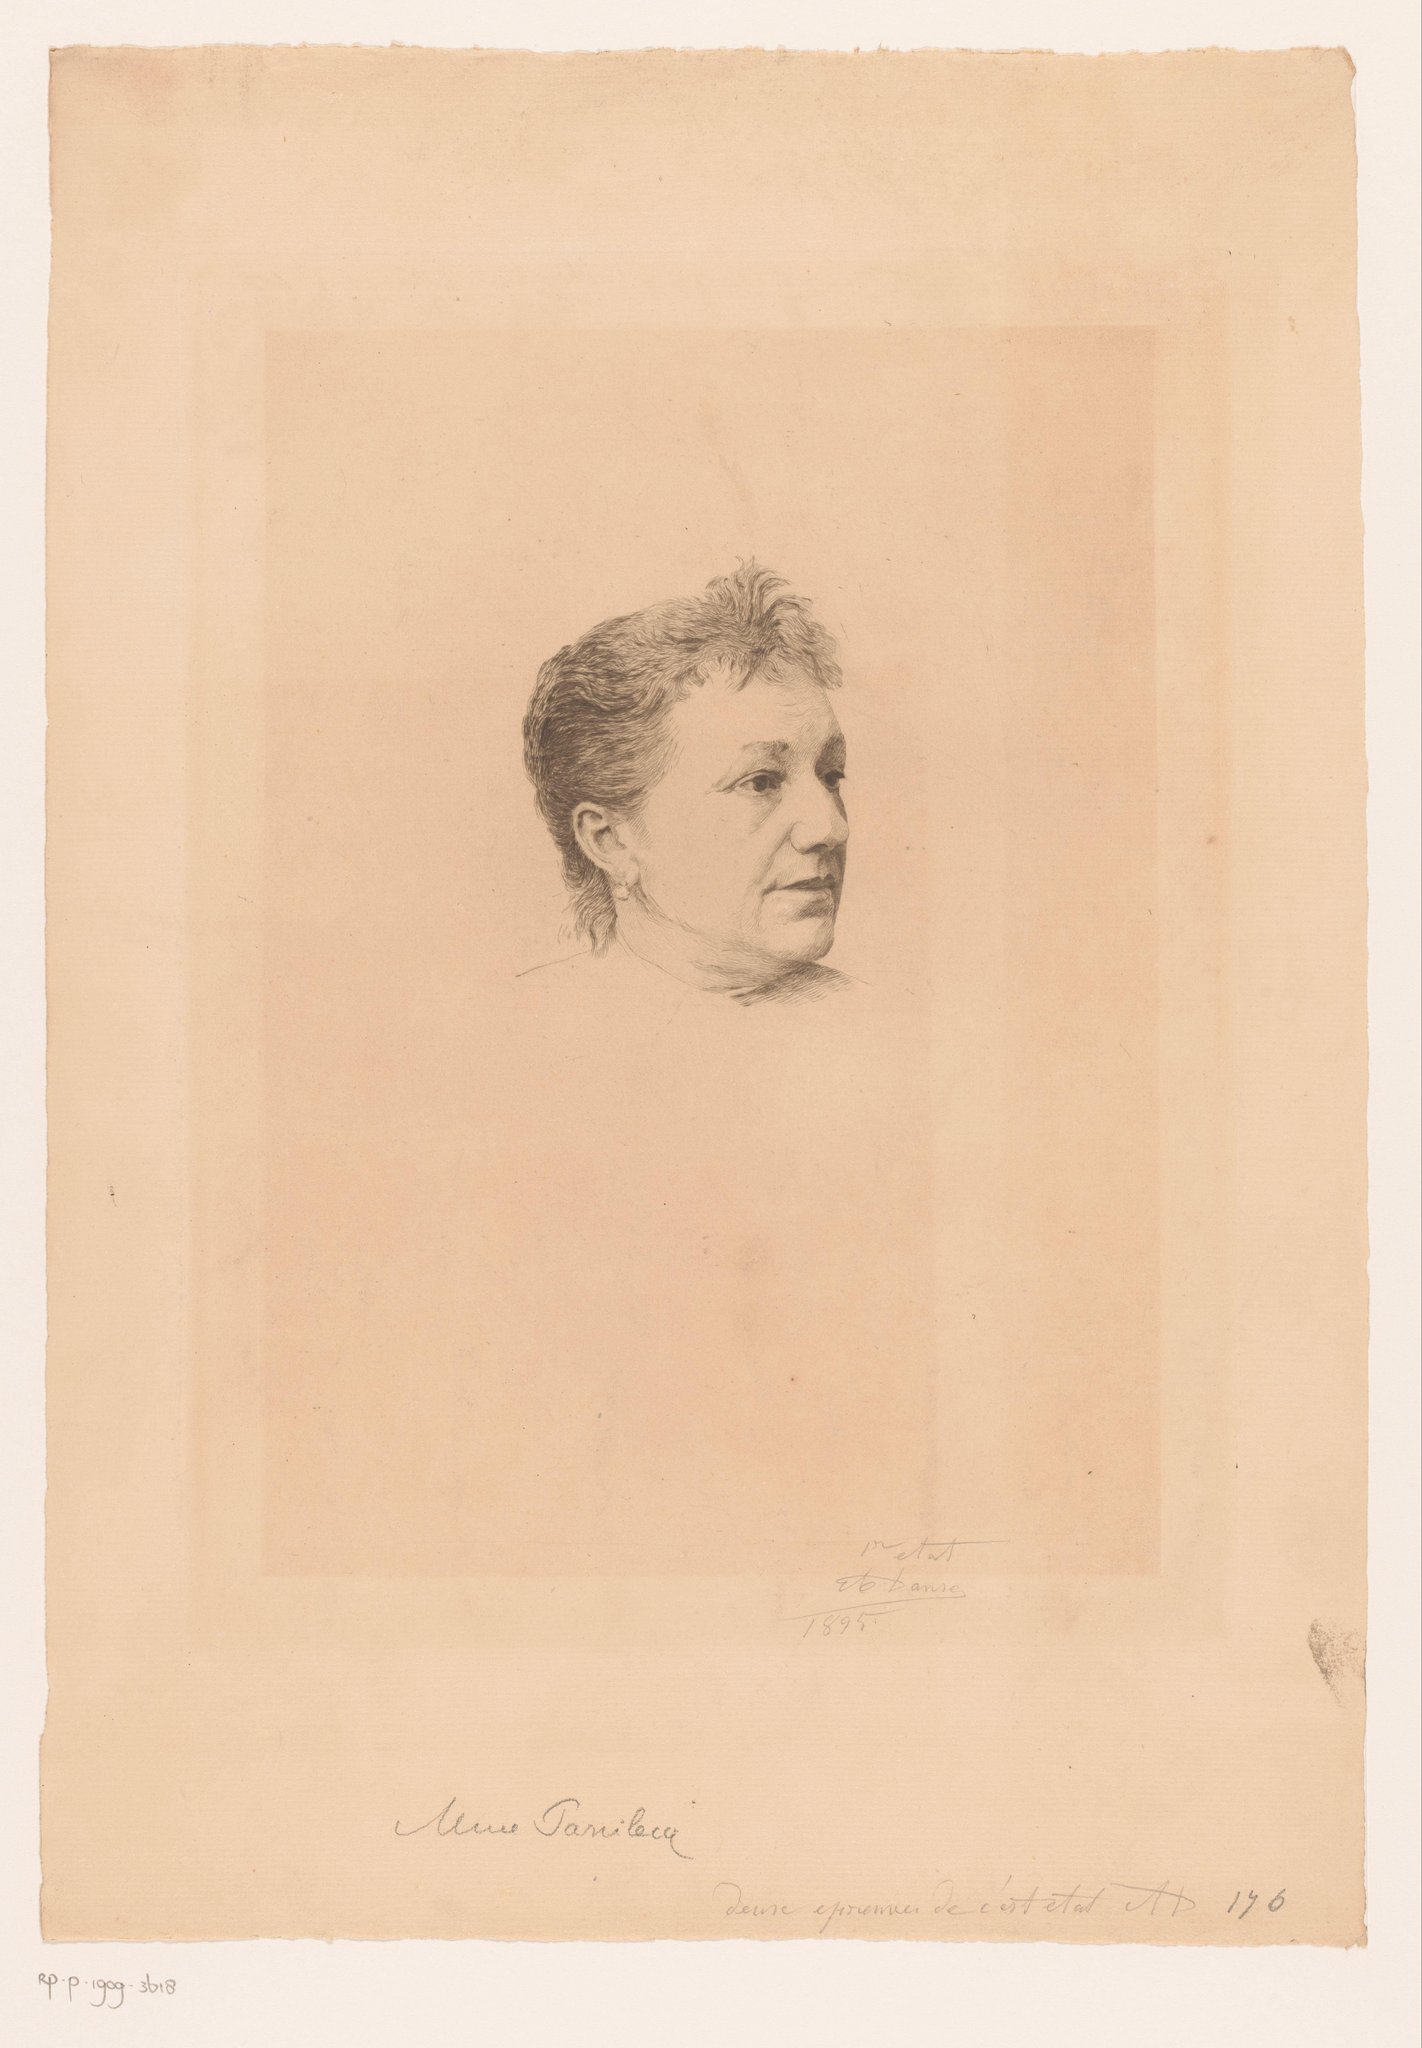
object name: print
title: Portret van een onbekende dame, mevrouw Panilecq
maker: auguste danse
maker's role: print maker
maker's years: 1829-1929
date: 1895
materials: paper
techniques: etching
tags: anonymous historical person portrayed alone - bb - woman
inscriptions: annotation: ‘1er état’, annotation: ‘deux epreuves de c'est etat’, watermark: ‘Wapenschild met Franse lelie boven monogram V.G.Z.’, annotation: ‘Mme Panilecq’, collector's mark: Lugt 2228